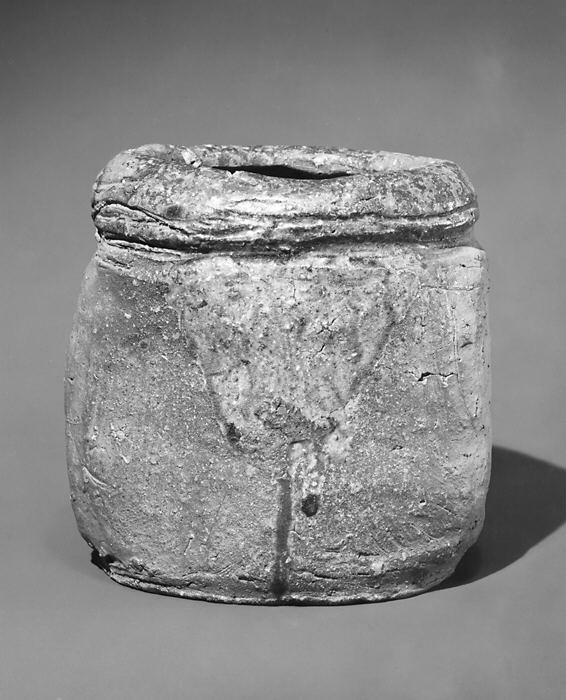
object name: water jar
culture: japanese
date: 1600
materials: stoneware